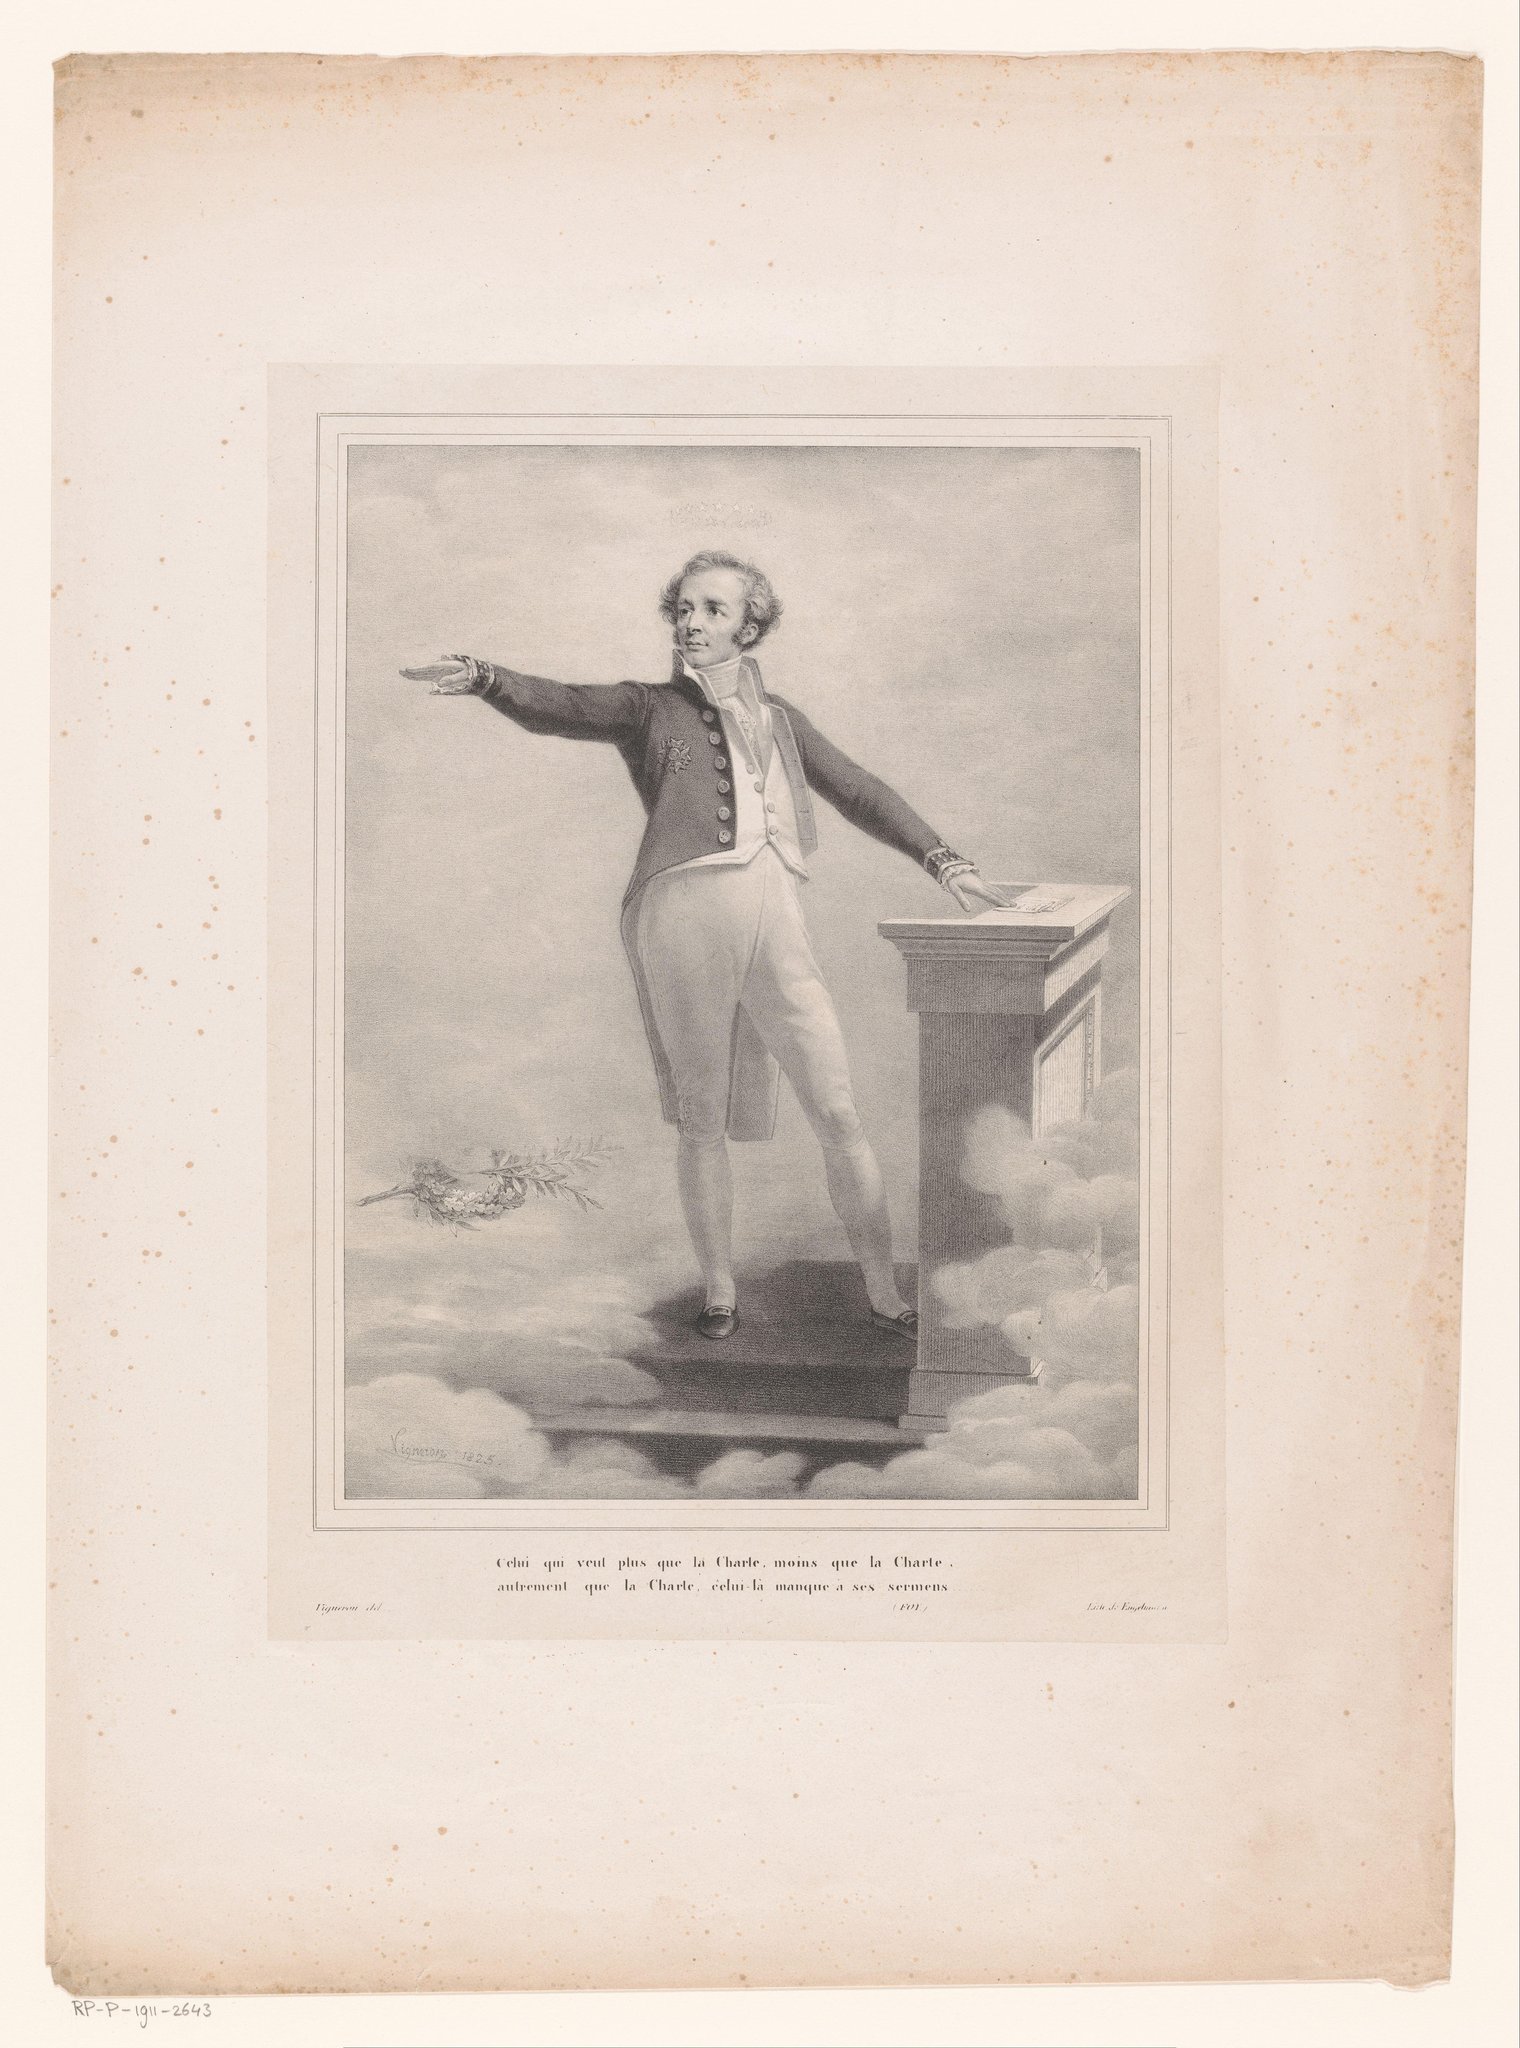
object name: print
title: Portret van Maximilien Sébastien Foy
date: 1825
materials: paper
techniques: lithograph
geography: paris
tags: paris, politician, maximilien sébastien foy, historical persons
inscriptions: collector's mark: Lugt 2228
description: Onder het portret een tweeregelig vers van de geportretteerde: Celui qui veut plus que la charte, moins que la charte, autrement que la charte, celui-là manque à ses sermens.